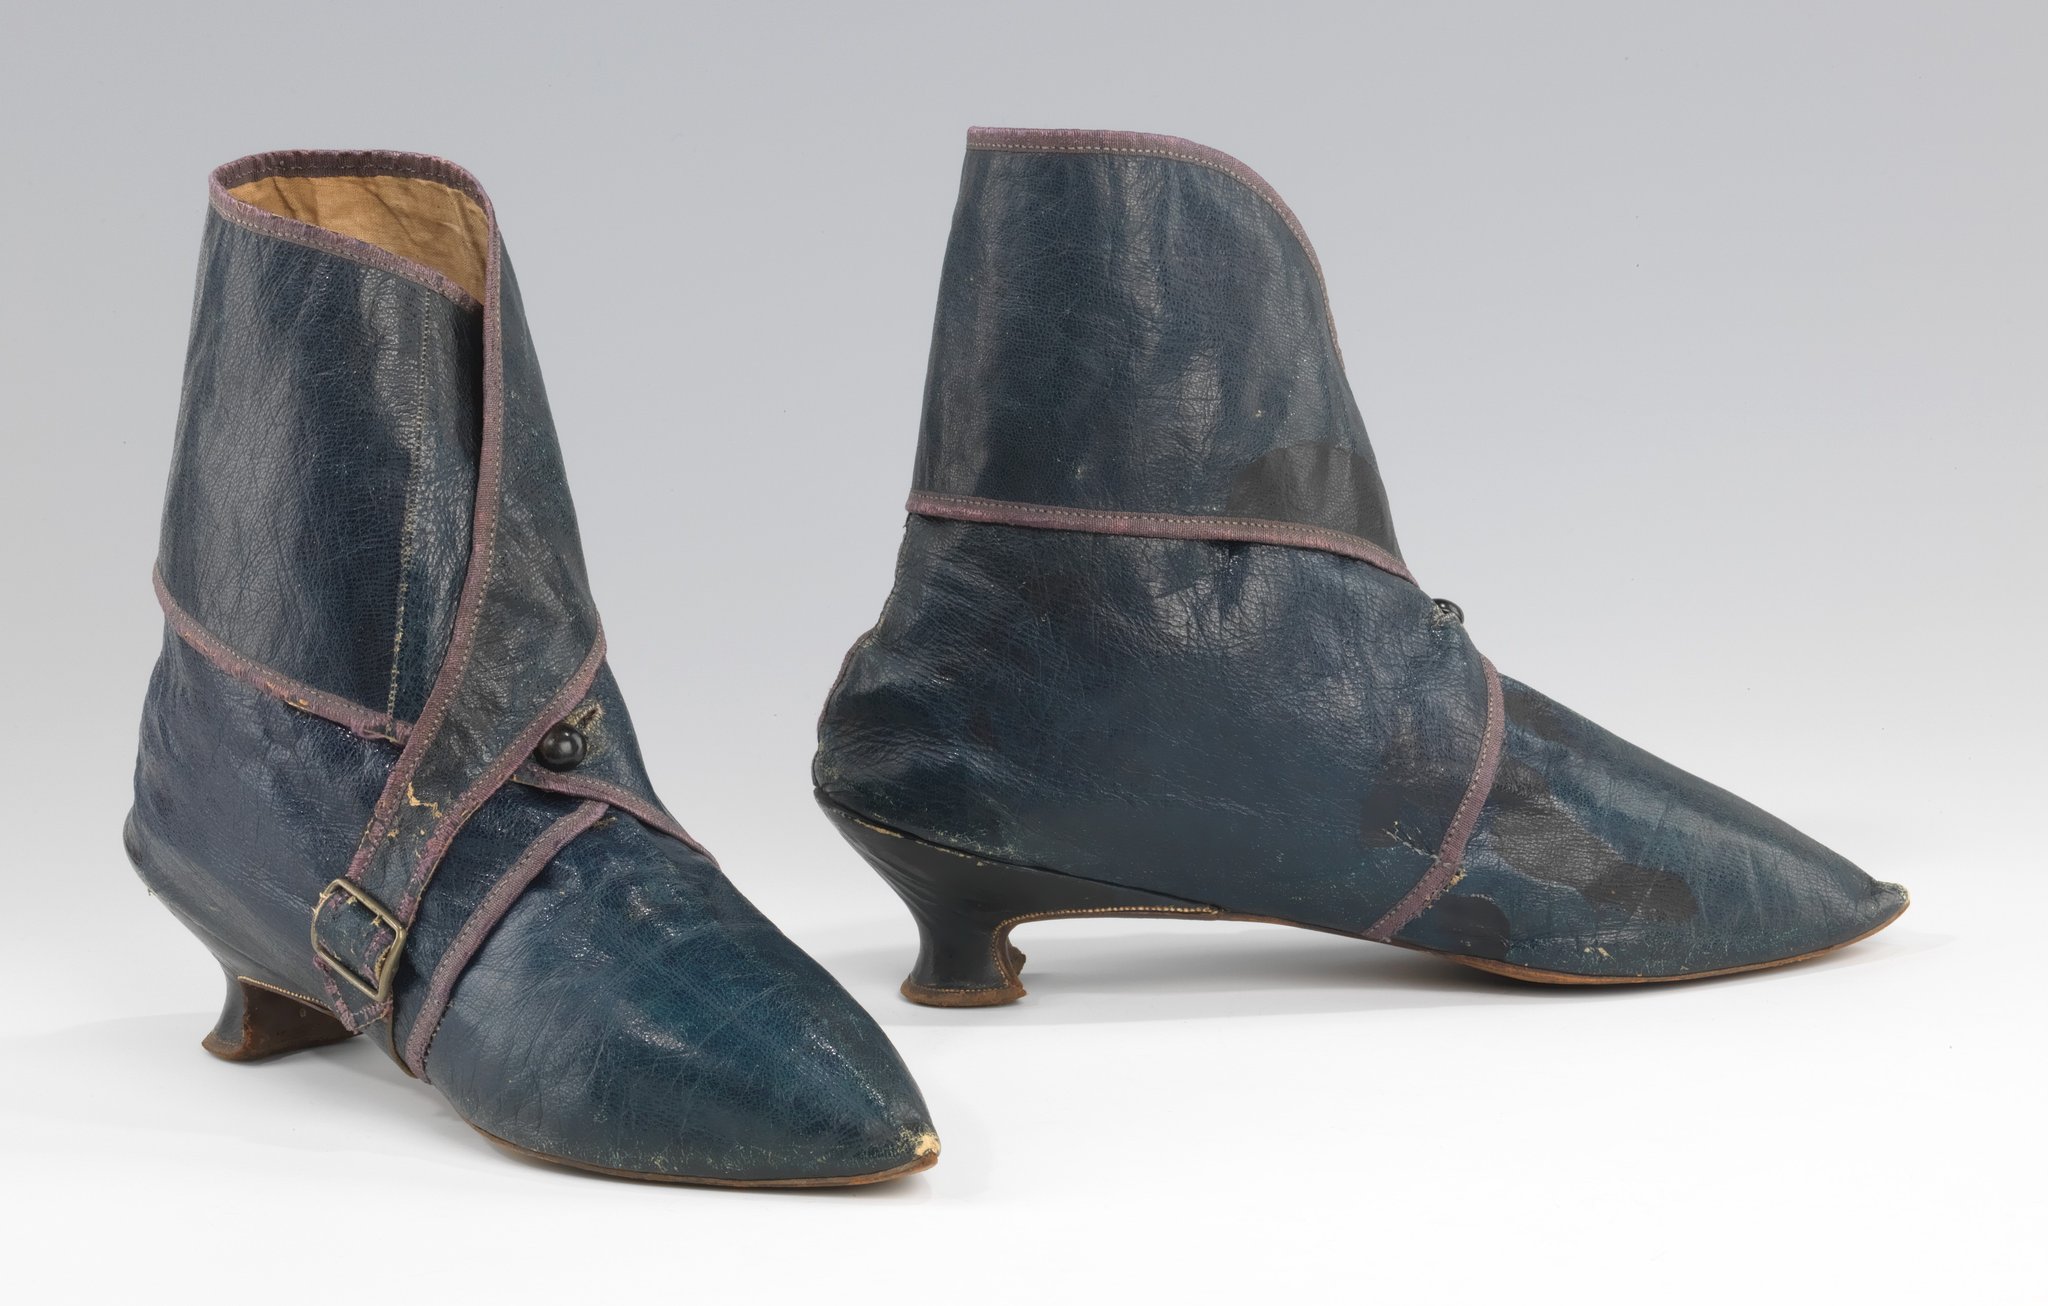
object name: boot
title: Boots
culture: european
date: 1795-1810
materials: leather